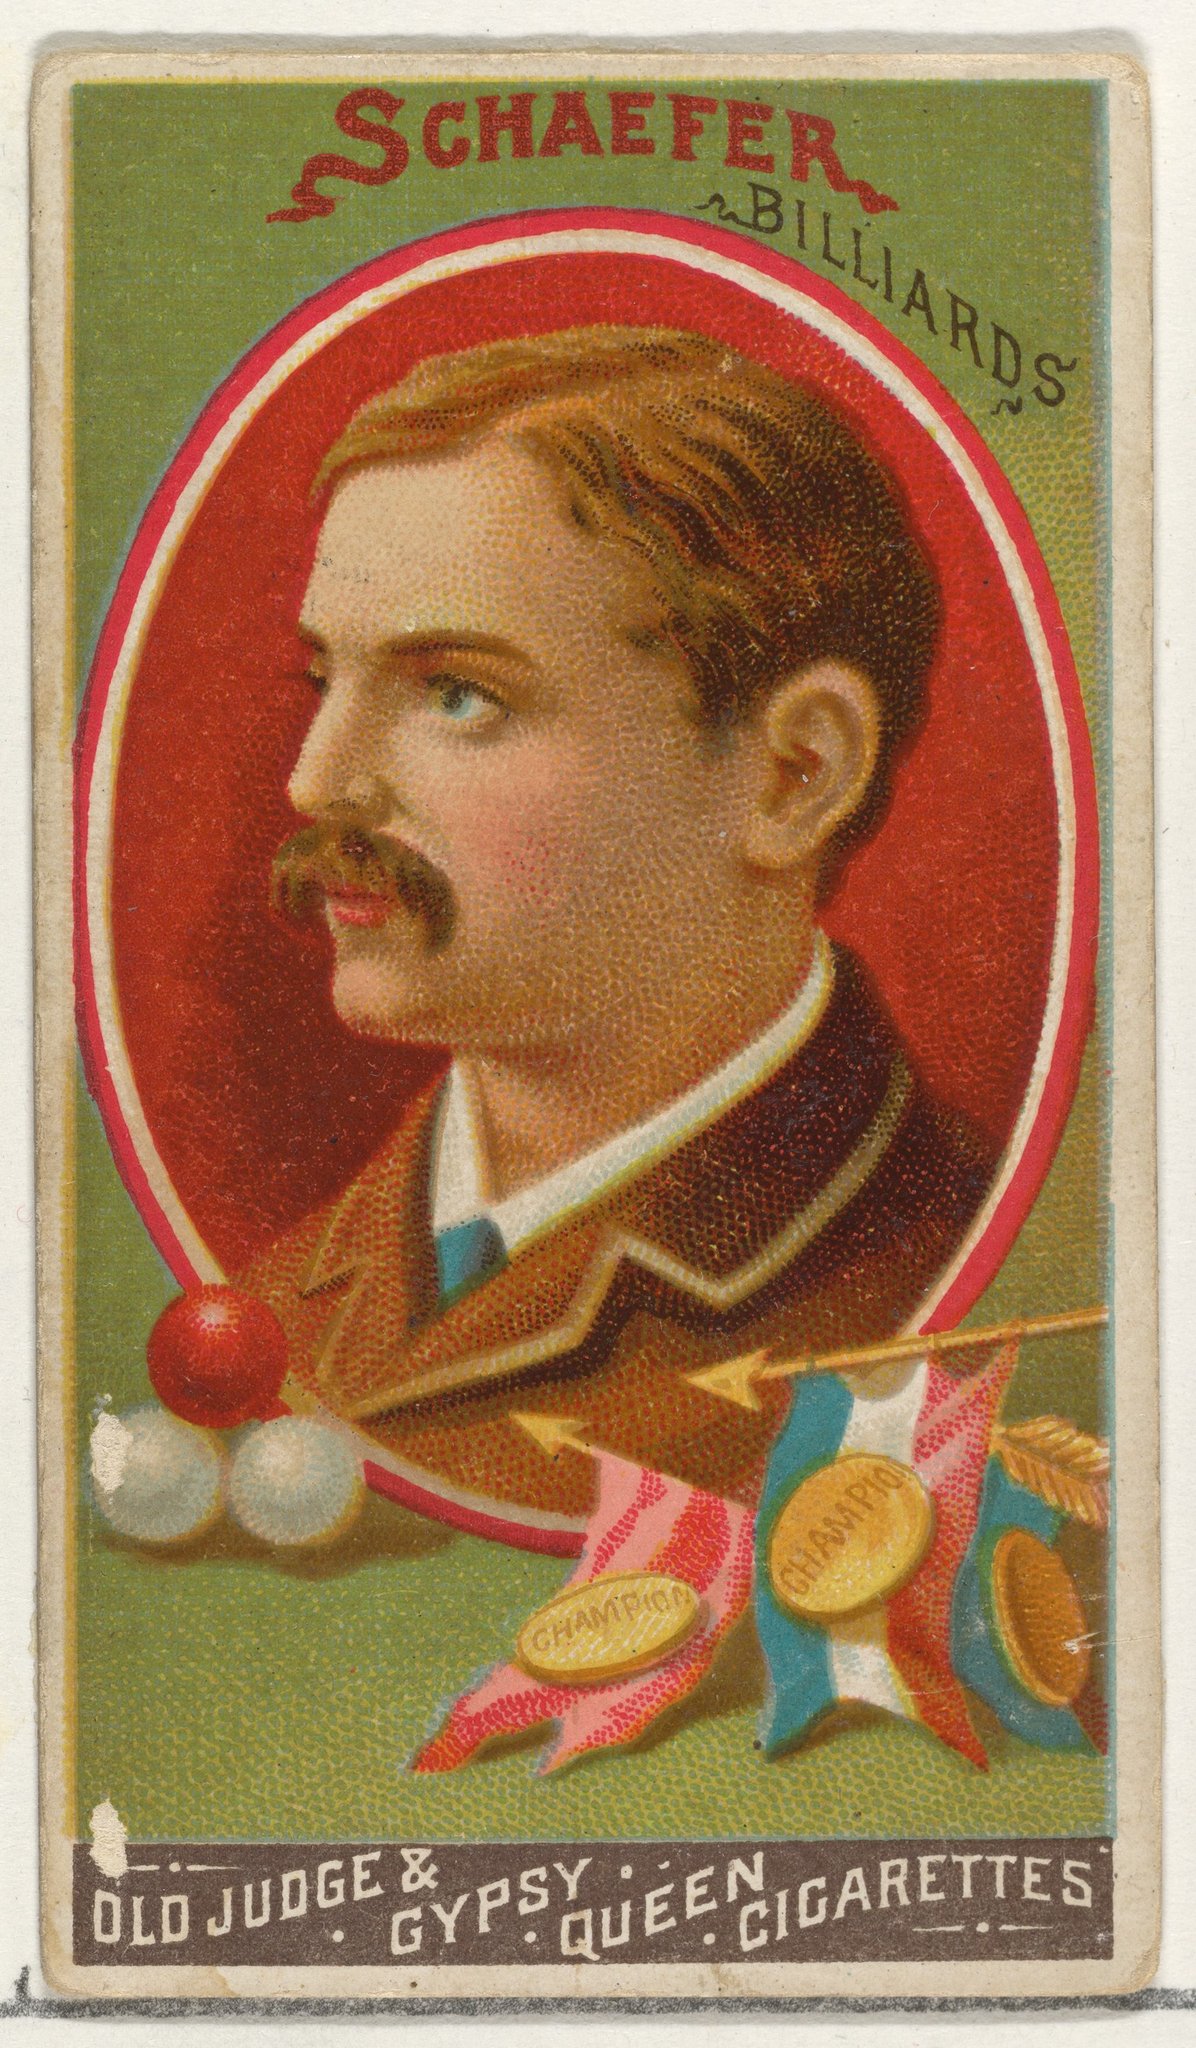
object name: print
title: Jacob Schaefer, Jr., Billiards, from the Goodwin Champion series for Old Judge and Gypsy Queen Cigarettes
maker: goodwin & company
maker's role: publisher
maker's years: 1850-1950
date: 1888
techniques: color lithograph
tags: men,profiles